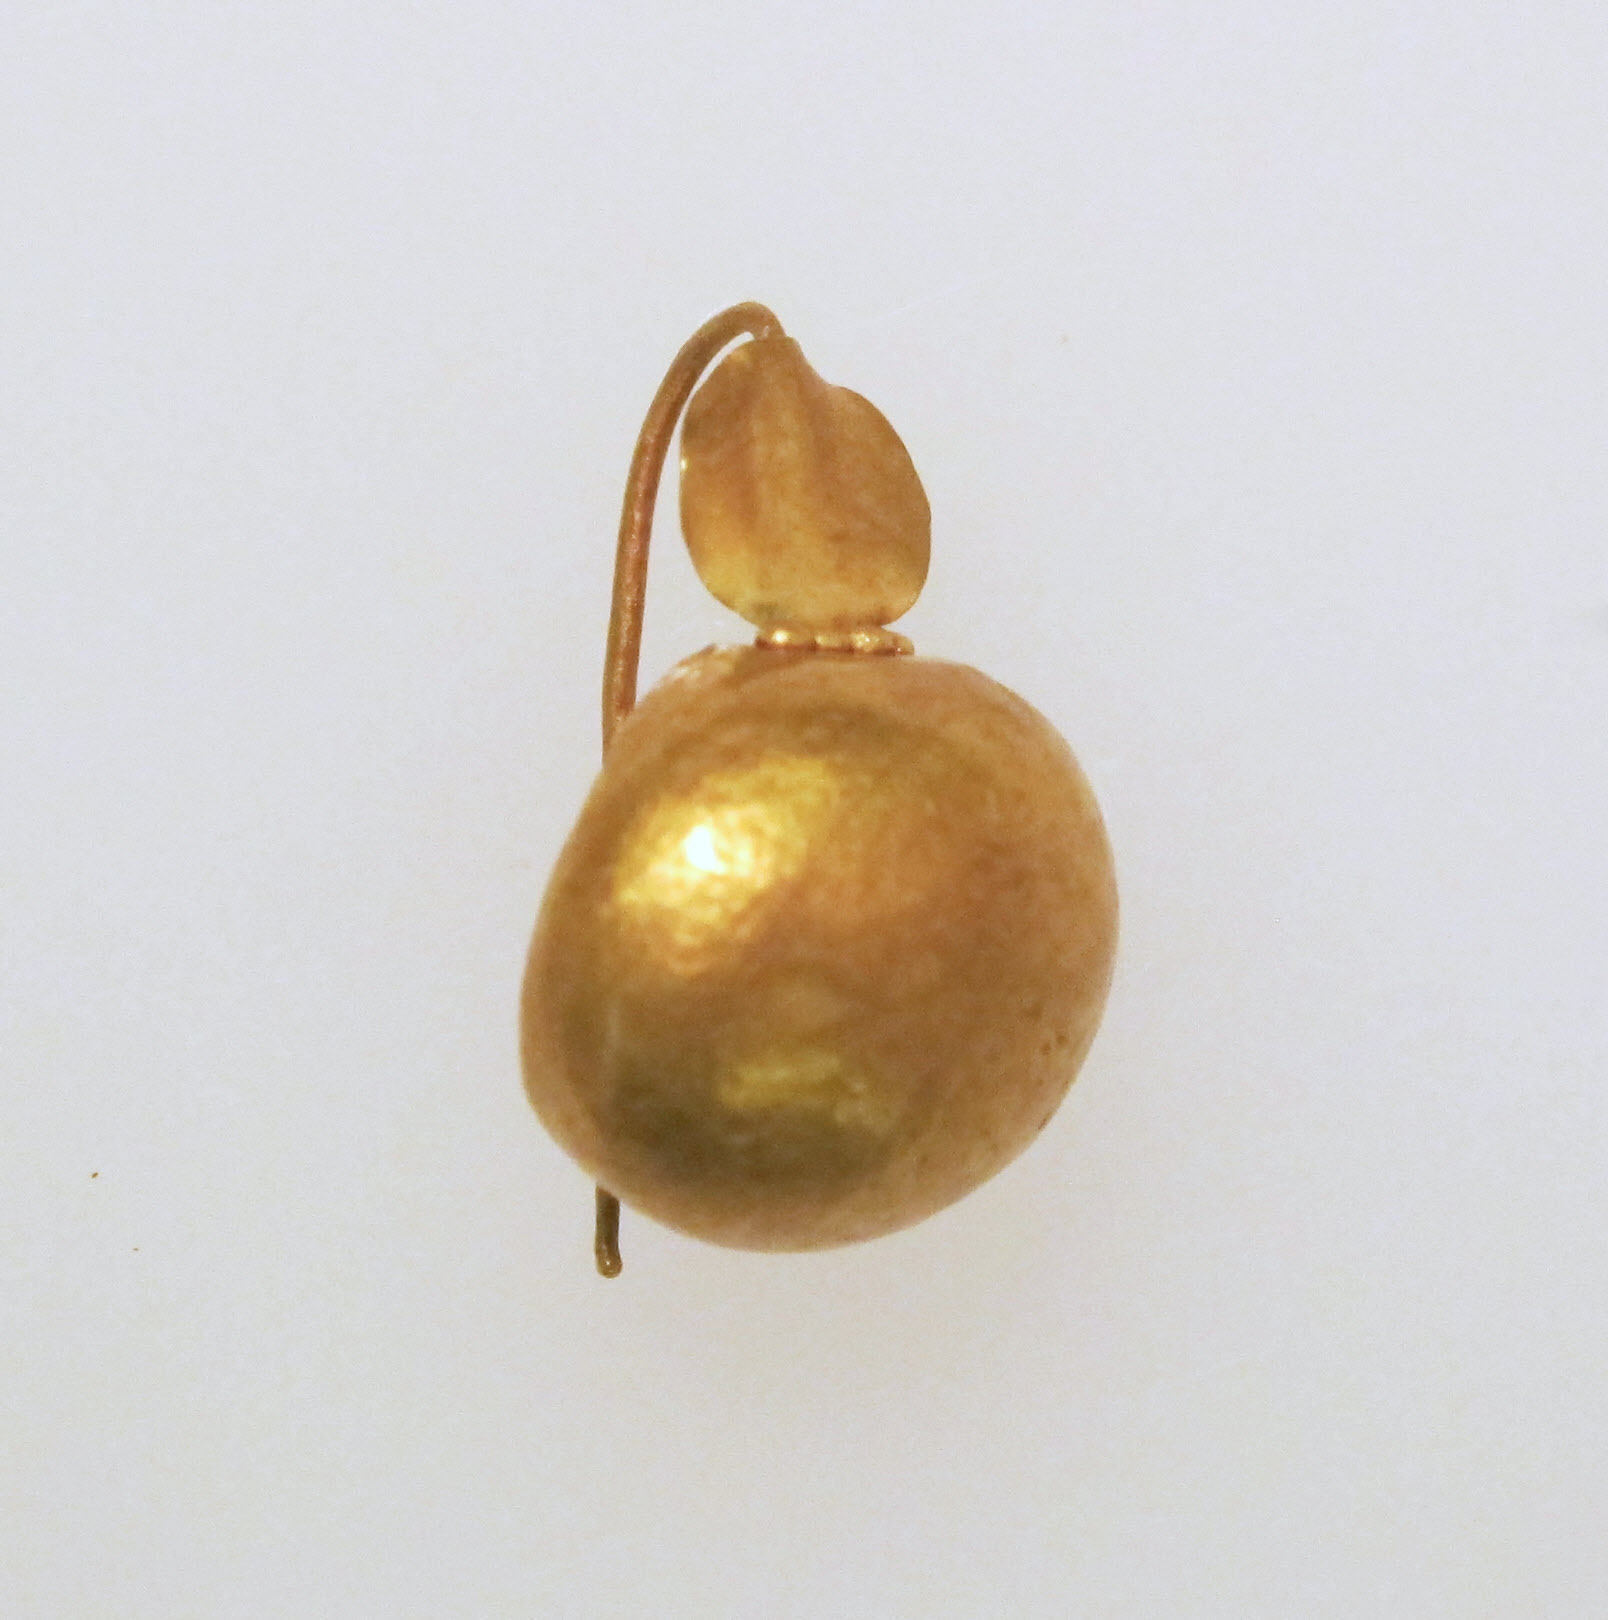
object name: earring hook type with sphere end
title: Earring-hook type with sphere ends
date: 7000 BCE-330 CE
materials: gold